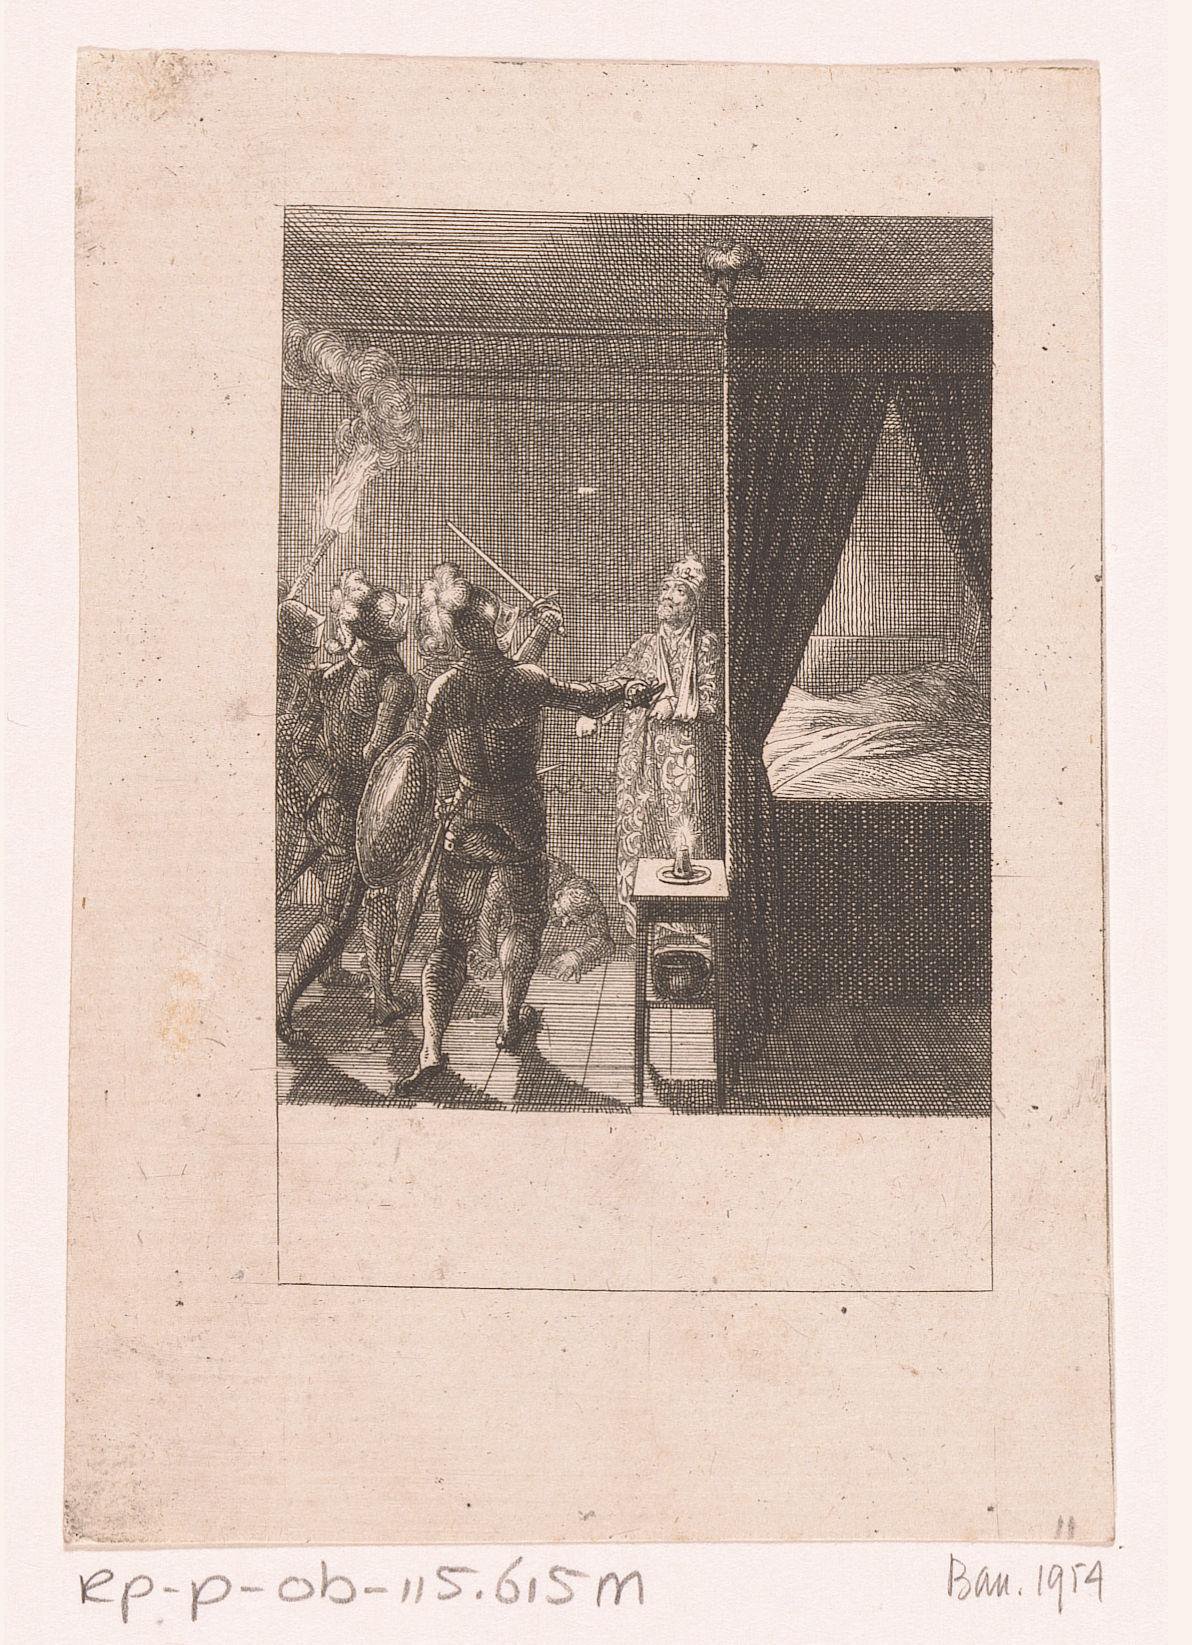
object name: print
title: Nachtelijke inval in het huis van Coligny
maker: daniel nikolaus chodowiecki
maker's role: draughtsman, print maker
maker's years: 1726-1801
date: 1799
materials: paper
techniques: etching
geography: berlin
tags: gaspard de coligny (ii), surprise attack (stratagem), bedroom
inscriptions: collector's mark: Lugt 2228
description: Prent gebruikt voor: Historisch-genealogischer Kalender auf das Jahr 1799 und 1800. Die Geschichte der Bartholomäusnacht oder die Bluthochzeit zu Paris. Berlijn: Johann Friedrich Unger, [1799].